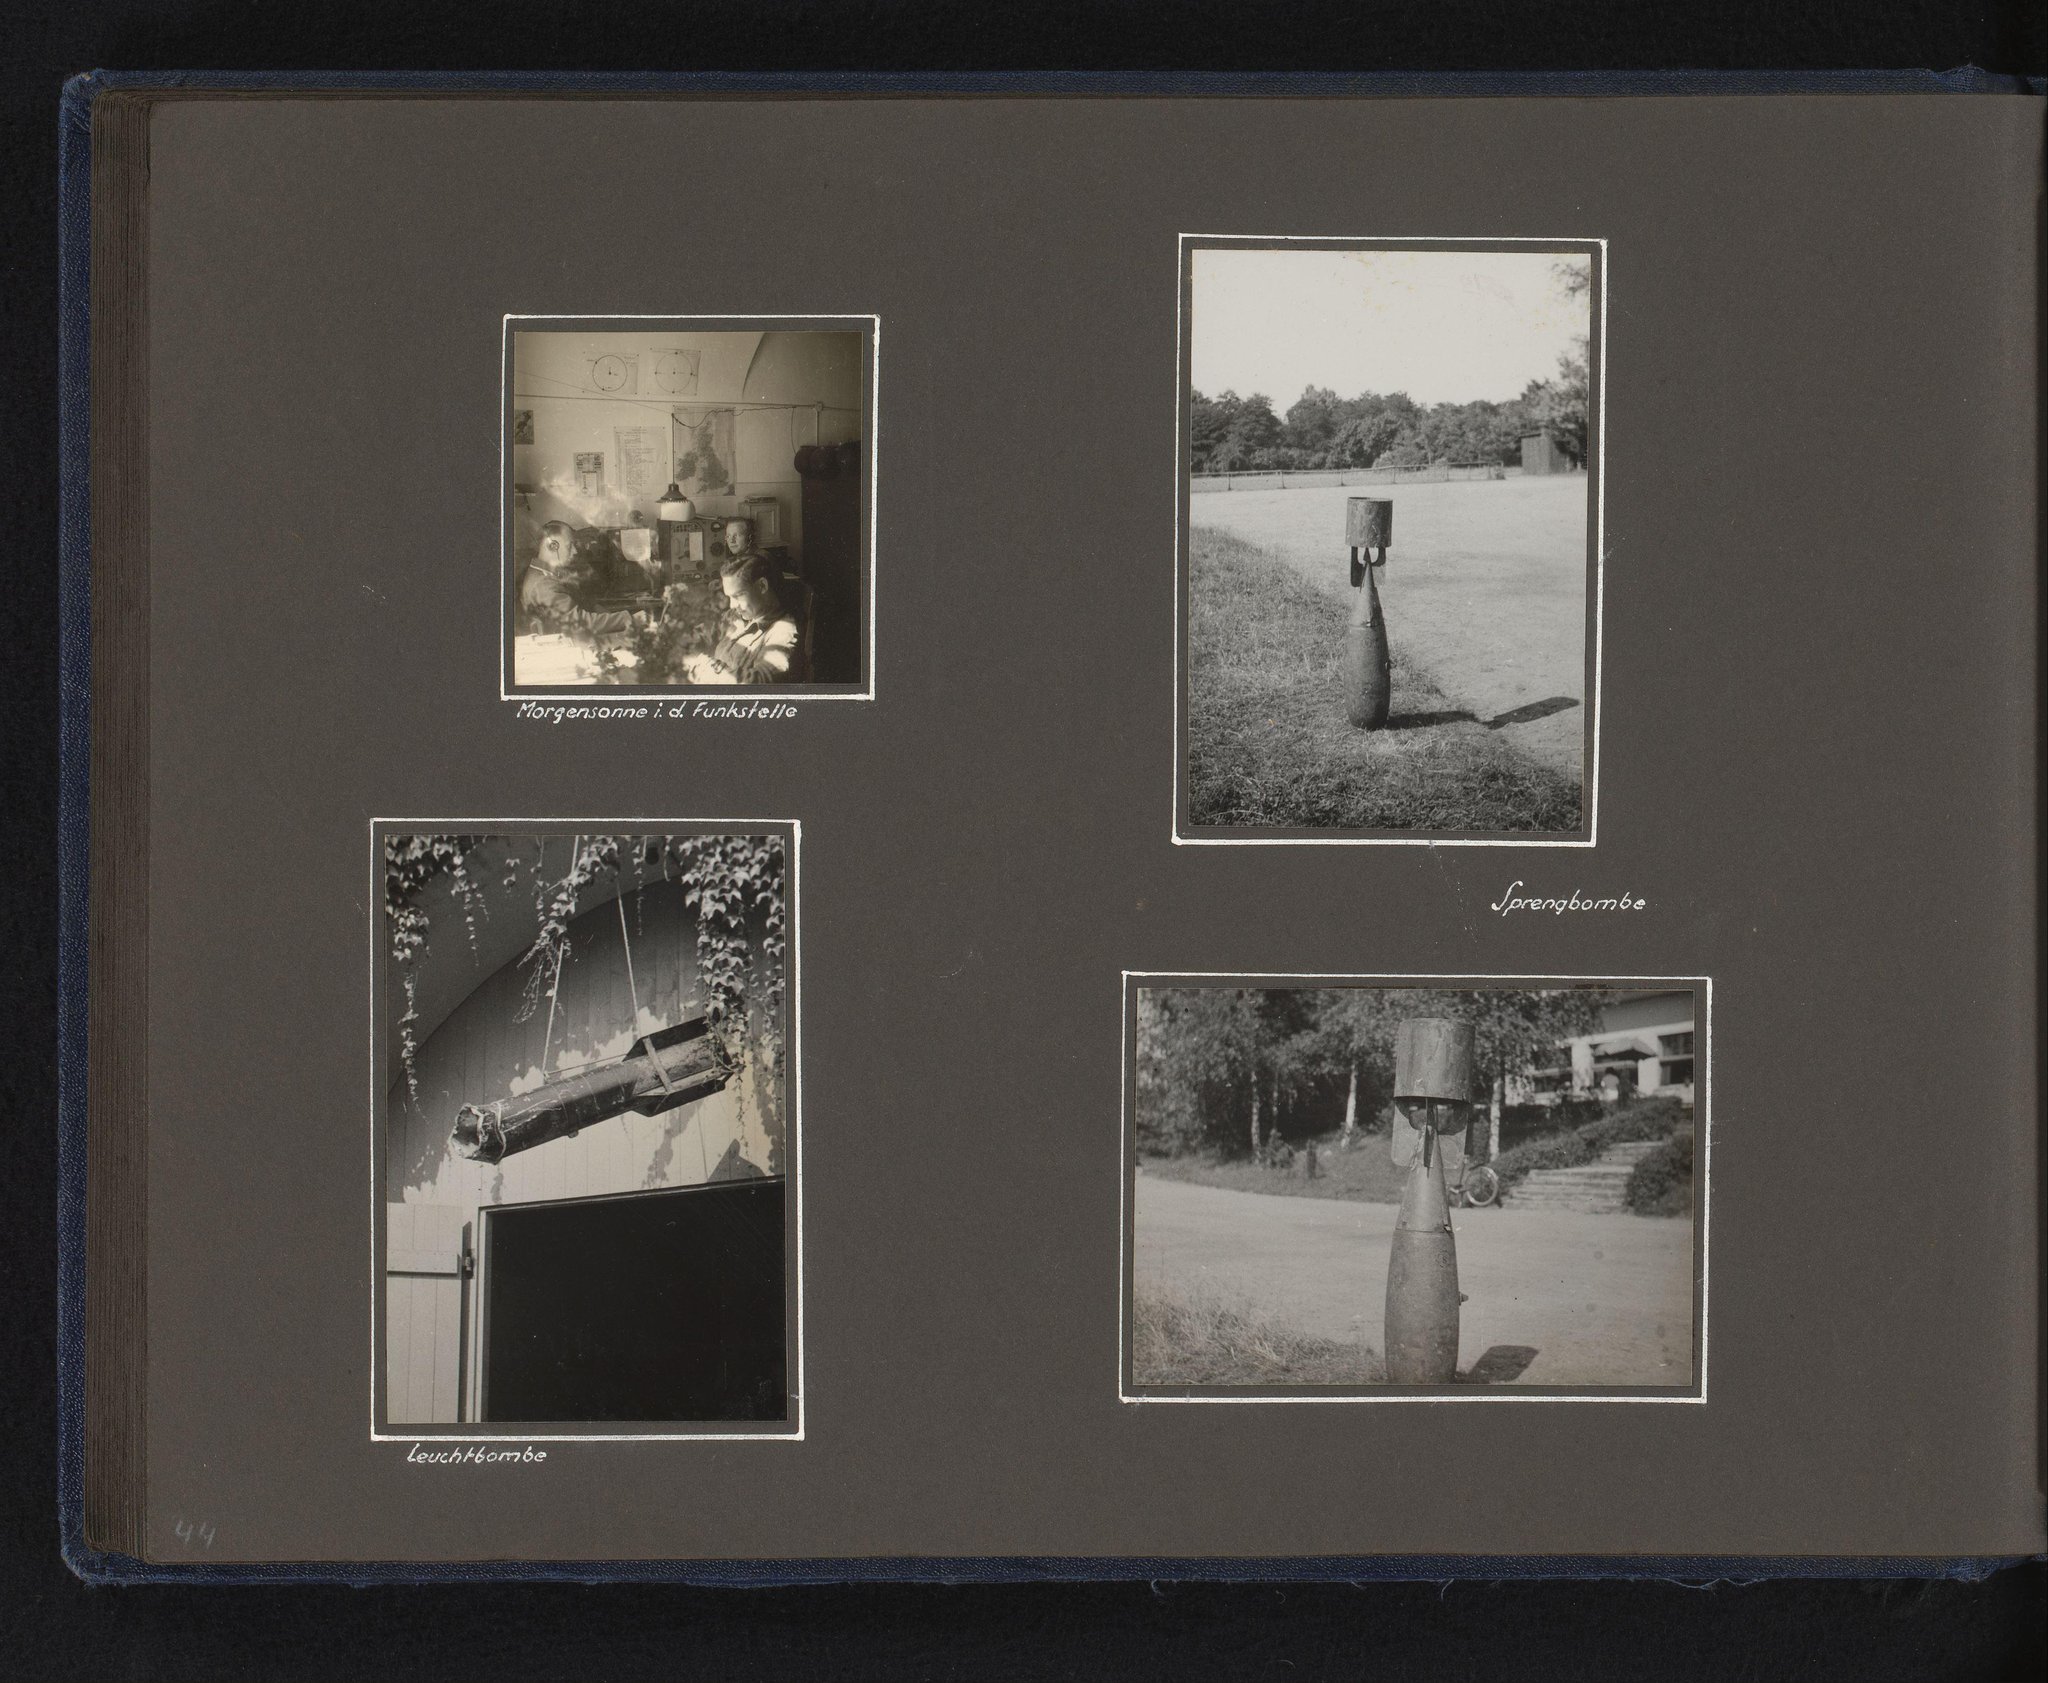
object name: album leaf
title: Bommen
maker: Anonymous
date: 1940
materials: paper, photographic support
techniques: gelatin silver print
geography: germany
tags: projectiles, explosives, etc. (with name), communication (military), radiotelegraph, walkie-talkie, germany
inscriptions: inscription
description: Albumblad met vier foto's van bommen en van de radioinstallatie (Funkstelle), 1940. Onderdeel van een Duits militair album Tweede Wereldoorlog 1939-1940.